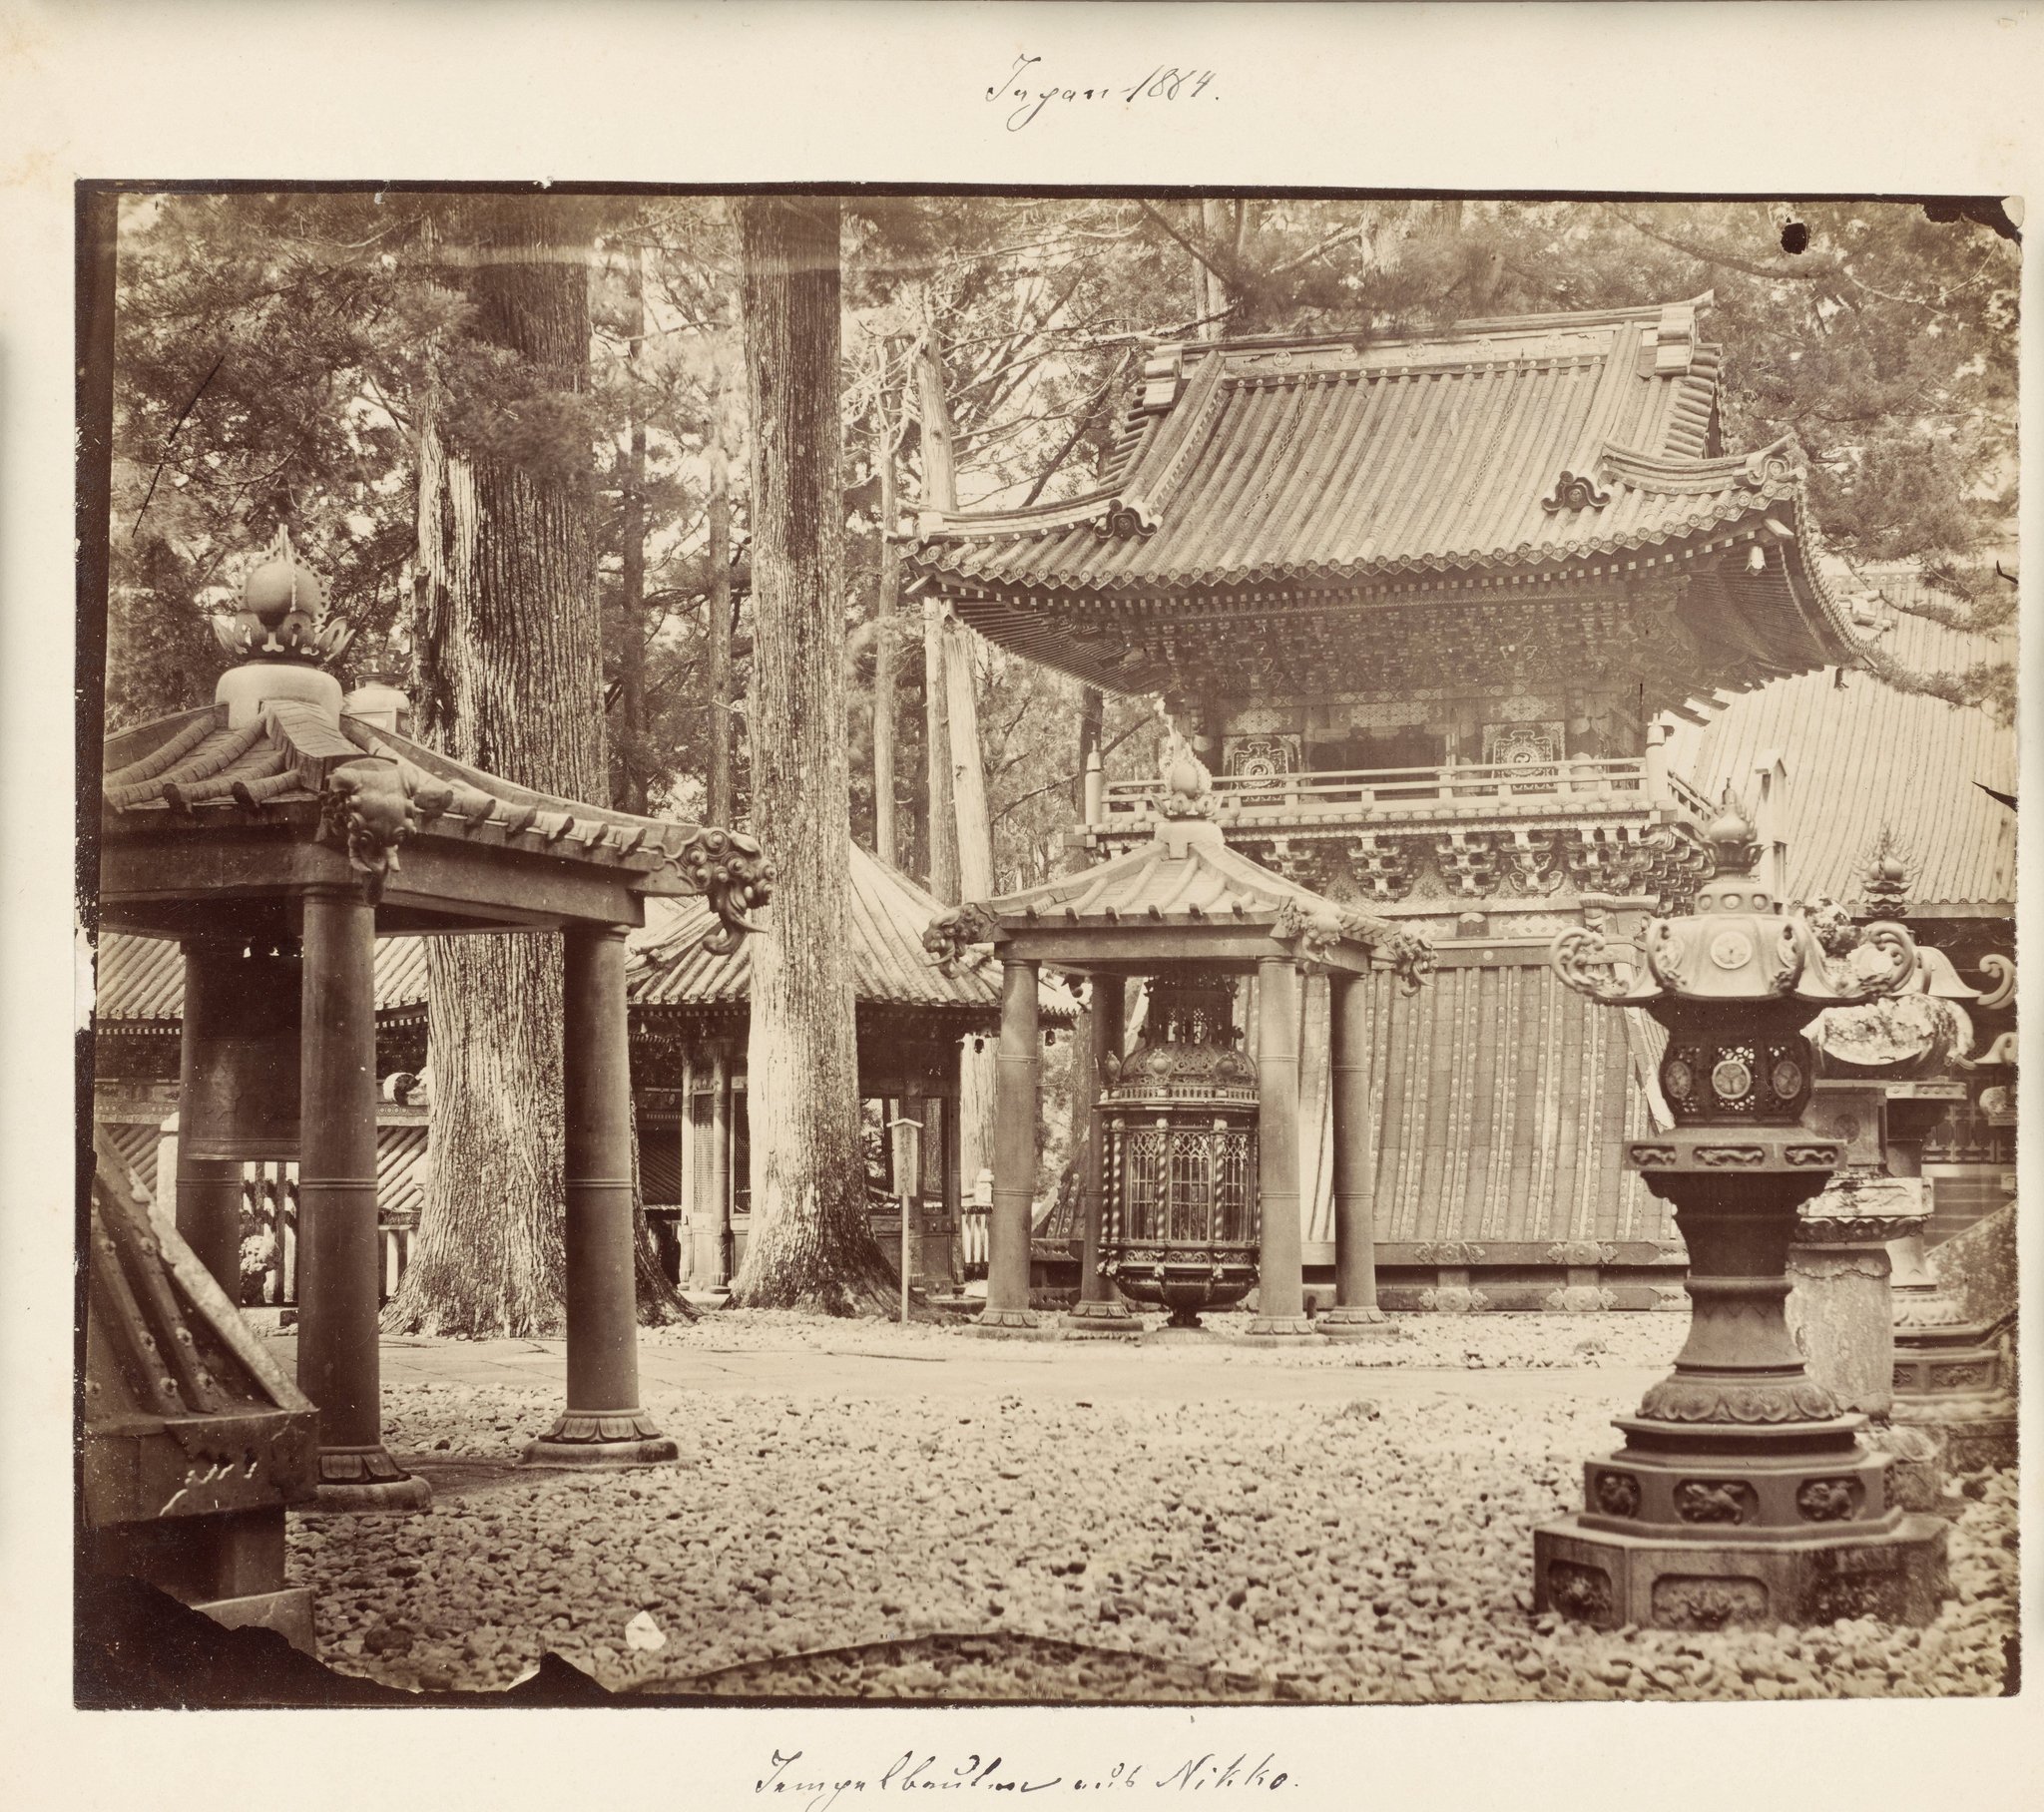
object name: photograph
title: Japan 1884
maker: Anonymous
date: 1884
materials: cardboard, paper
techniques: albumen print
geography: nikkō tōshō-gū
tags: temple, shrine ~ shinto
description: Deze oranda dōrō (Nederlandse lantaarn) bij Nikkō Tōshō-gū was een geschenk van de V.O.C. aan de shōgun van Japan in 1643.